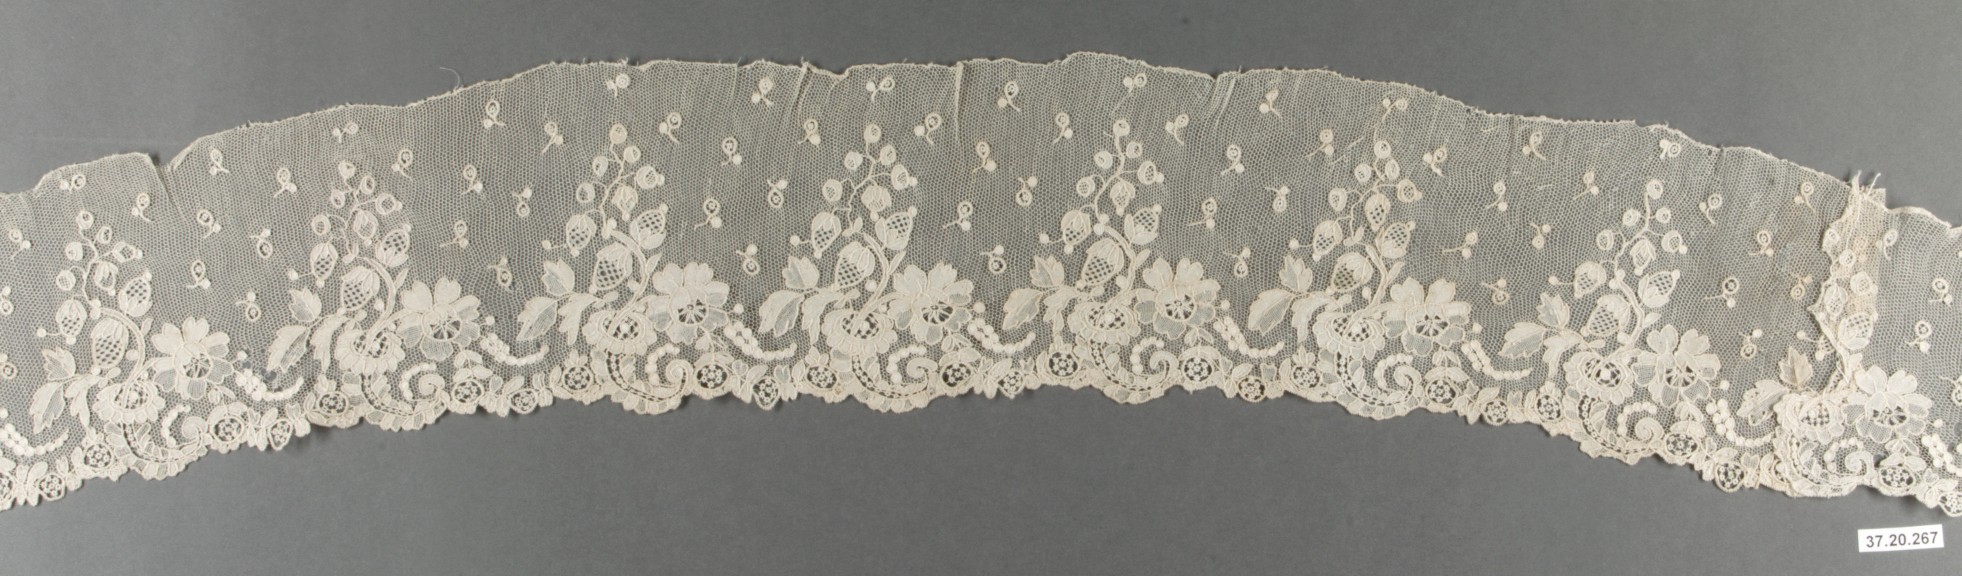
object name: border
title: Border (one of three)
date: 1801-1900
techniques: lace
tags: flowers